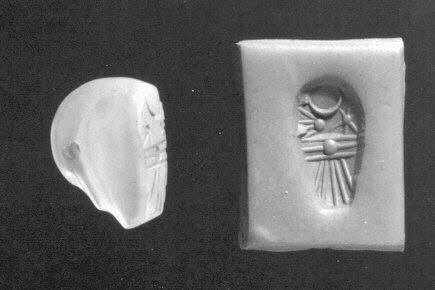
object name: stamp seal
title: Stamp seal (duck-shaped) with divine symbols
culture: assyrian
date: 700-601 BCE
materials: stone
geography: mesopotamia